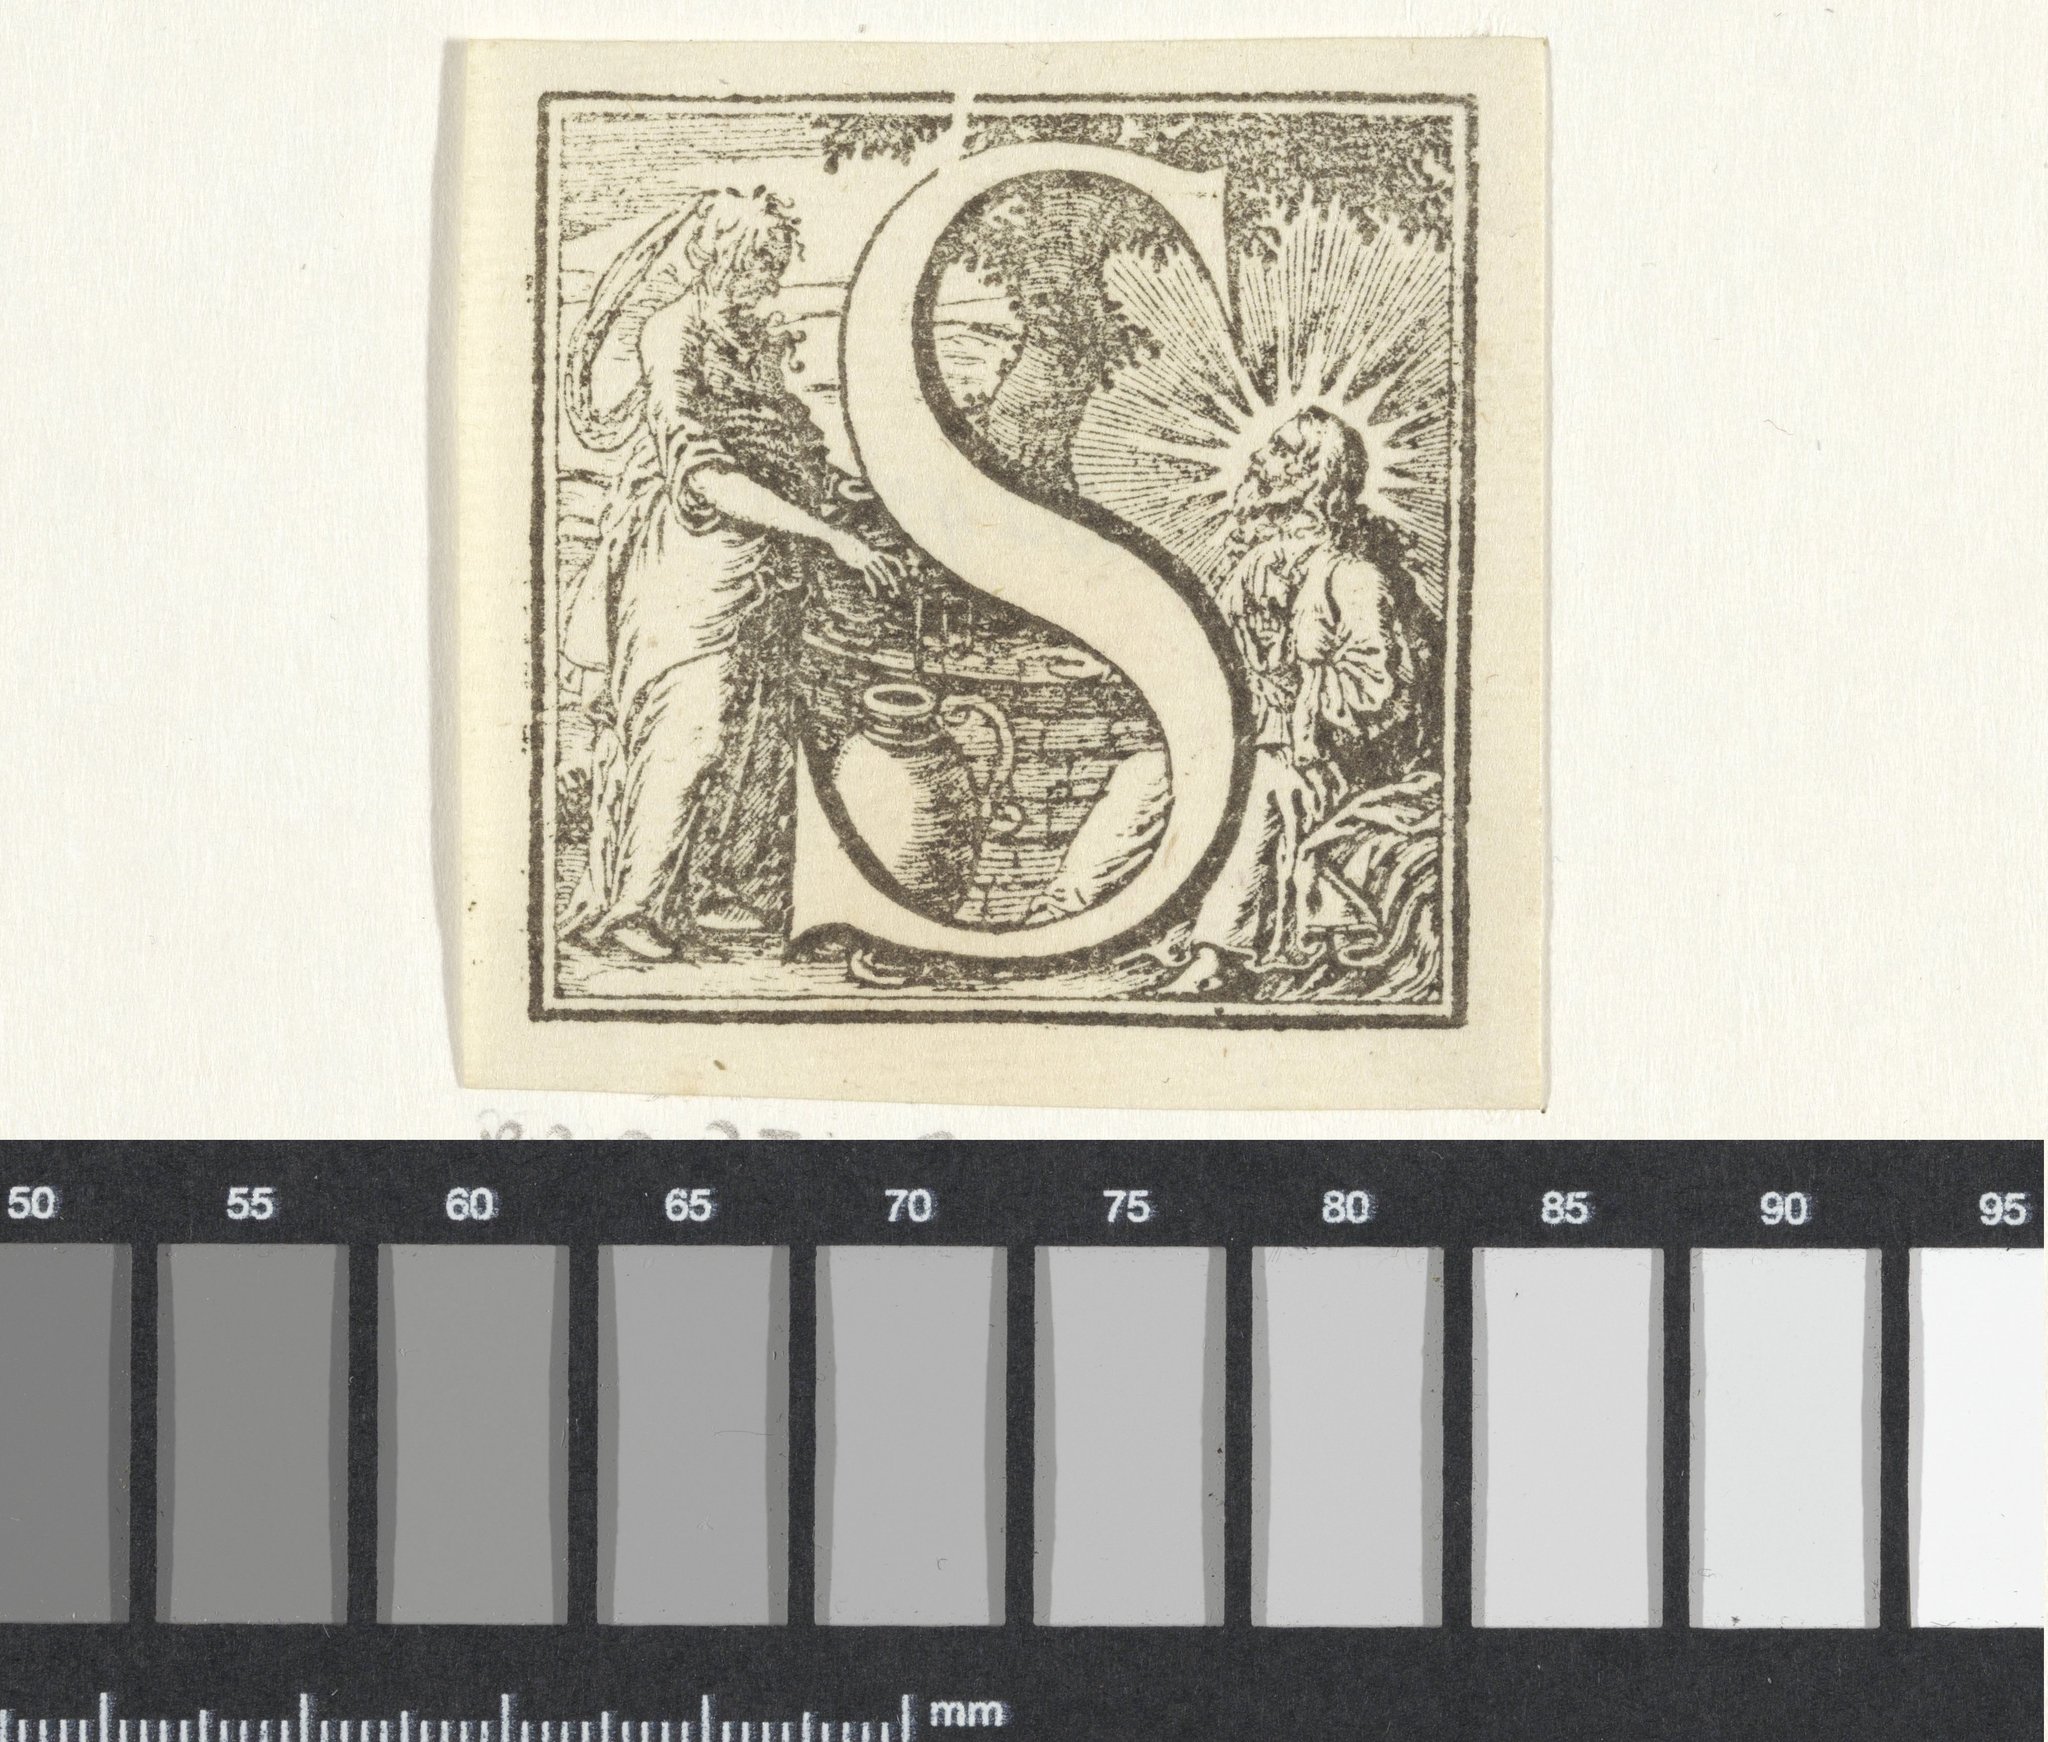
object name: print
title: Letter S in een omlijsting met een voorstelling van Christus en de Samaritaanse vrouw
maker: Anonymous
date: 1600-1699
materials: paper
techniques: woodcut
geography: netherlands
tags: christ and the woman of samaria: sitting at jacob's well he asks her for a drink from her jug, fancy letters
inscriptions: collector's mark: Lugt 240